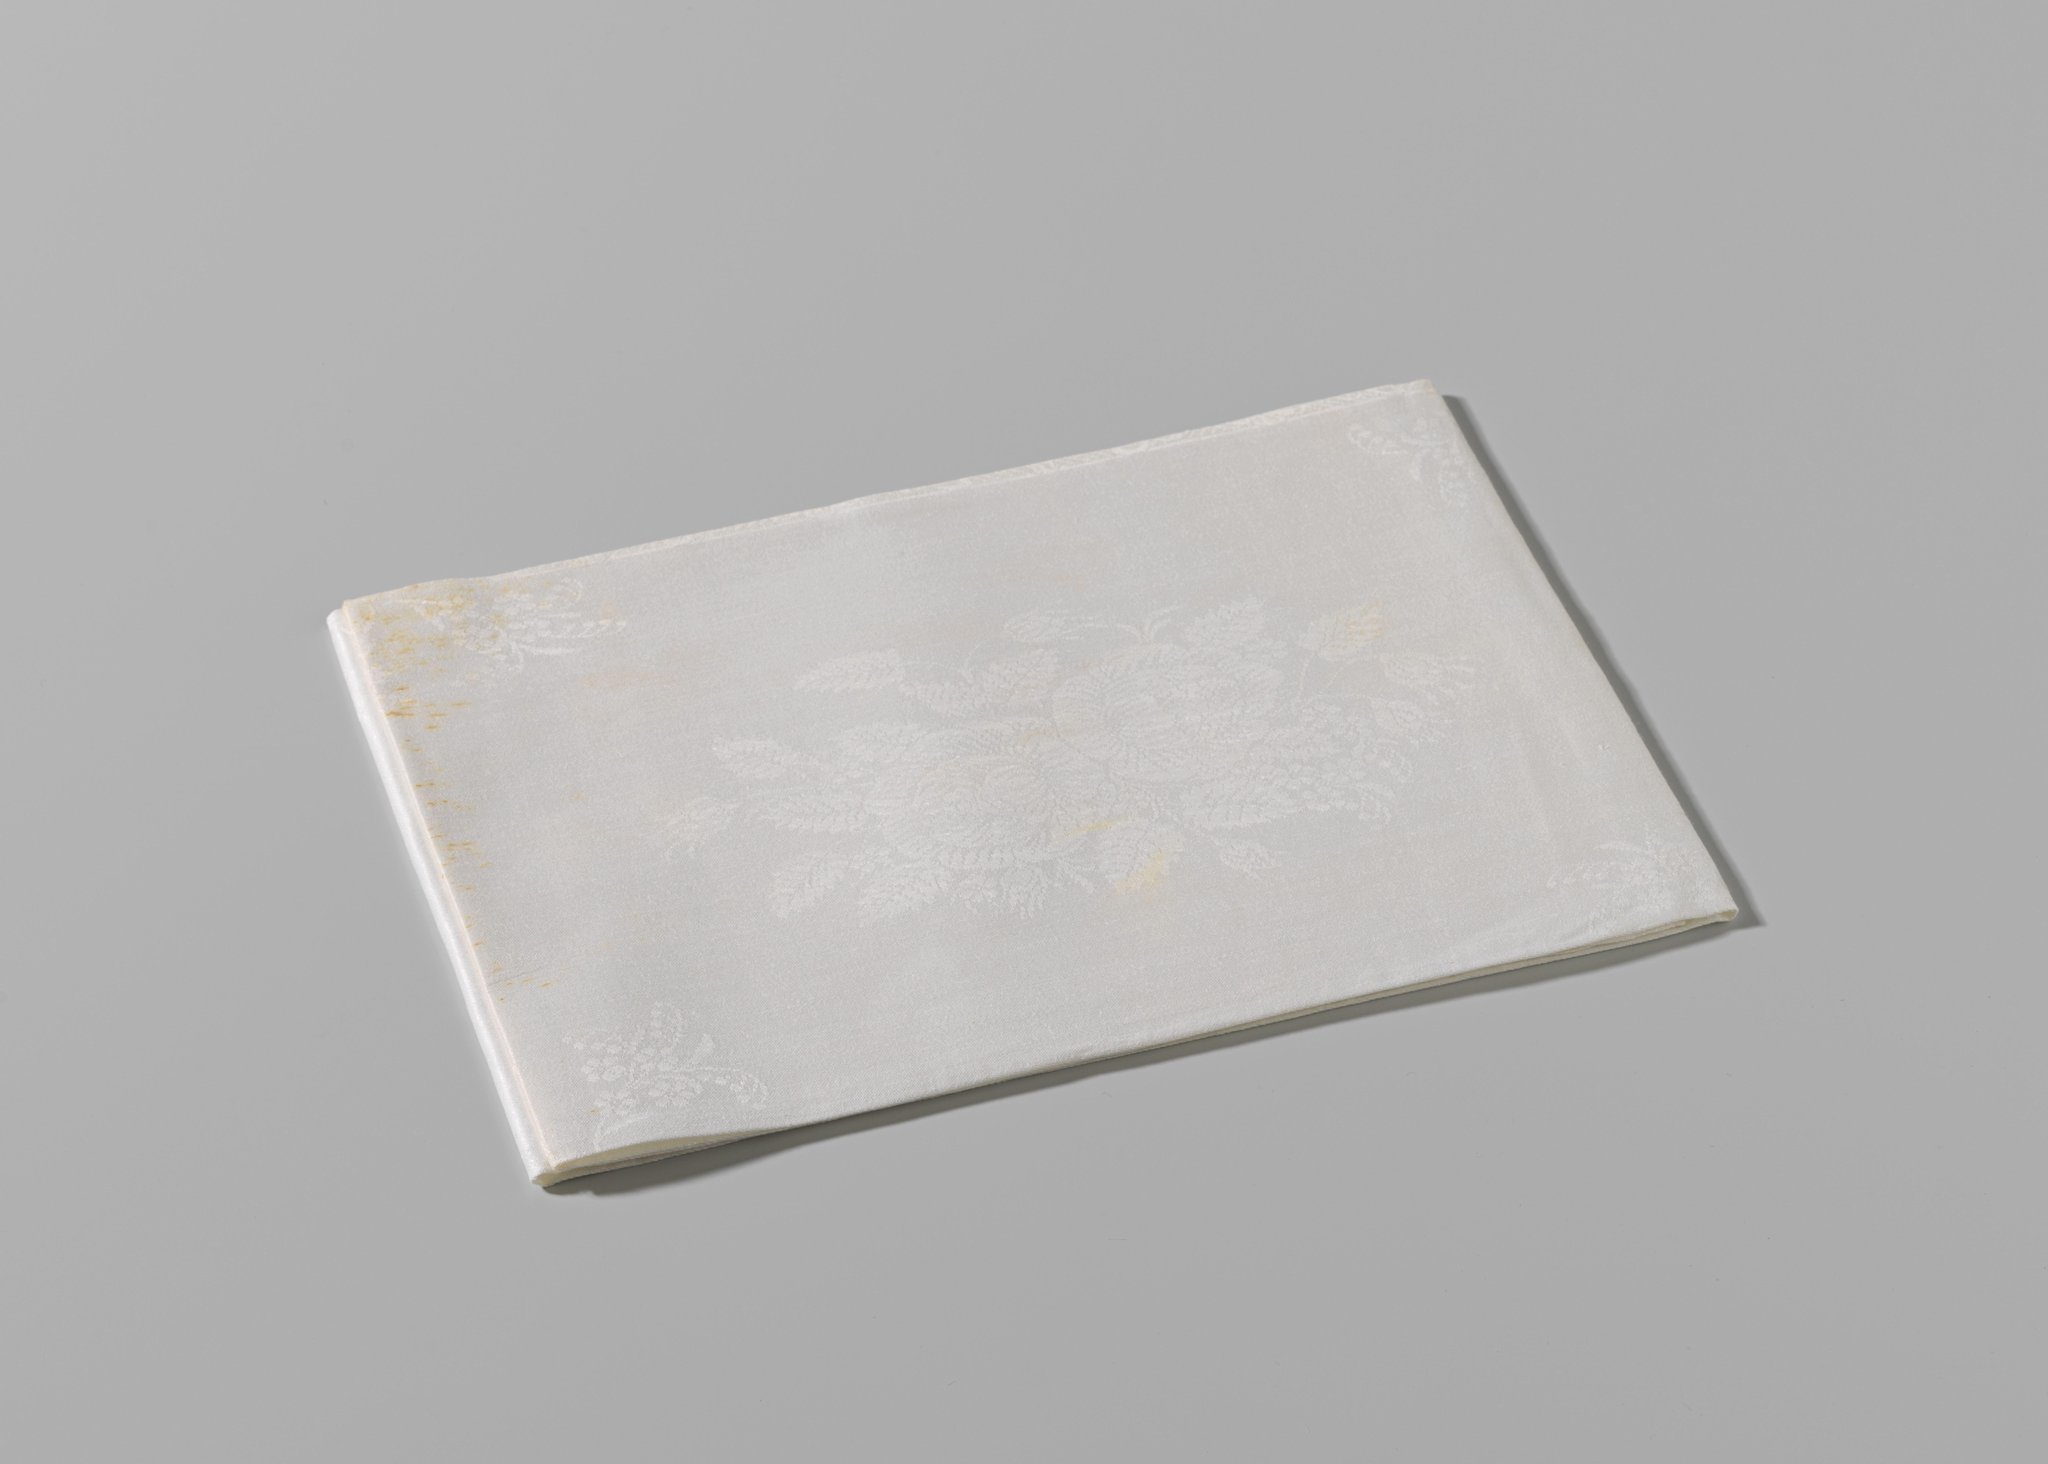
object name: napkin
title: Servet met rozen en vergeet-mij-nietjes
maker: Anonymous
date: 1725-1749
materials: linen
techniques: damask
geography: dresden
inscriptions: mark: ‘BS 18’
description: Servet van linnendamast met rozen en vergeet-mij-nietjes. Rozen- afgewisseld met vergeet-mij-niettuiltje. Brede rand met fijne symmetrische rocaillemotieven met rastervulling en met naar binnen gerichte bloemenvazen, waarin drie afwisselende bloembouquetten. Binnenzoom van C-motieven; buitenbegrenzing van bloemslingers. Rondom: blokkenrand.